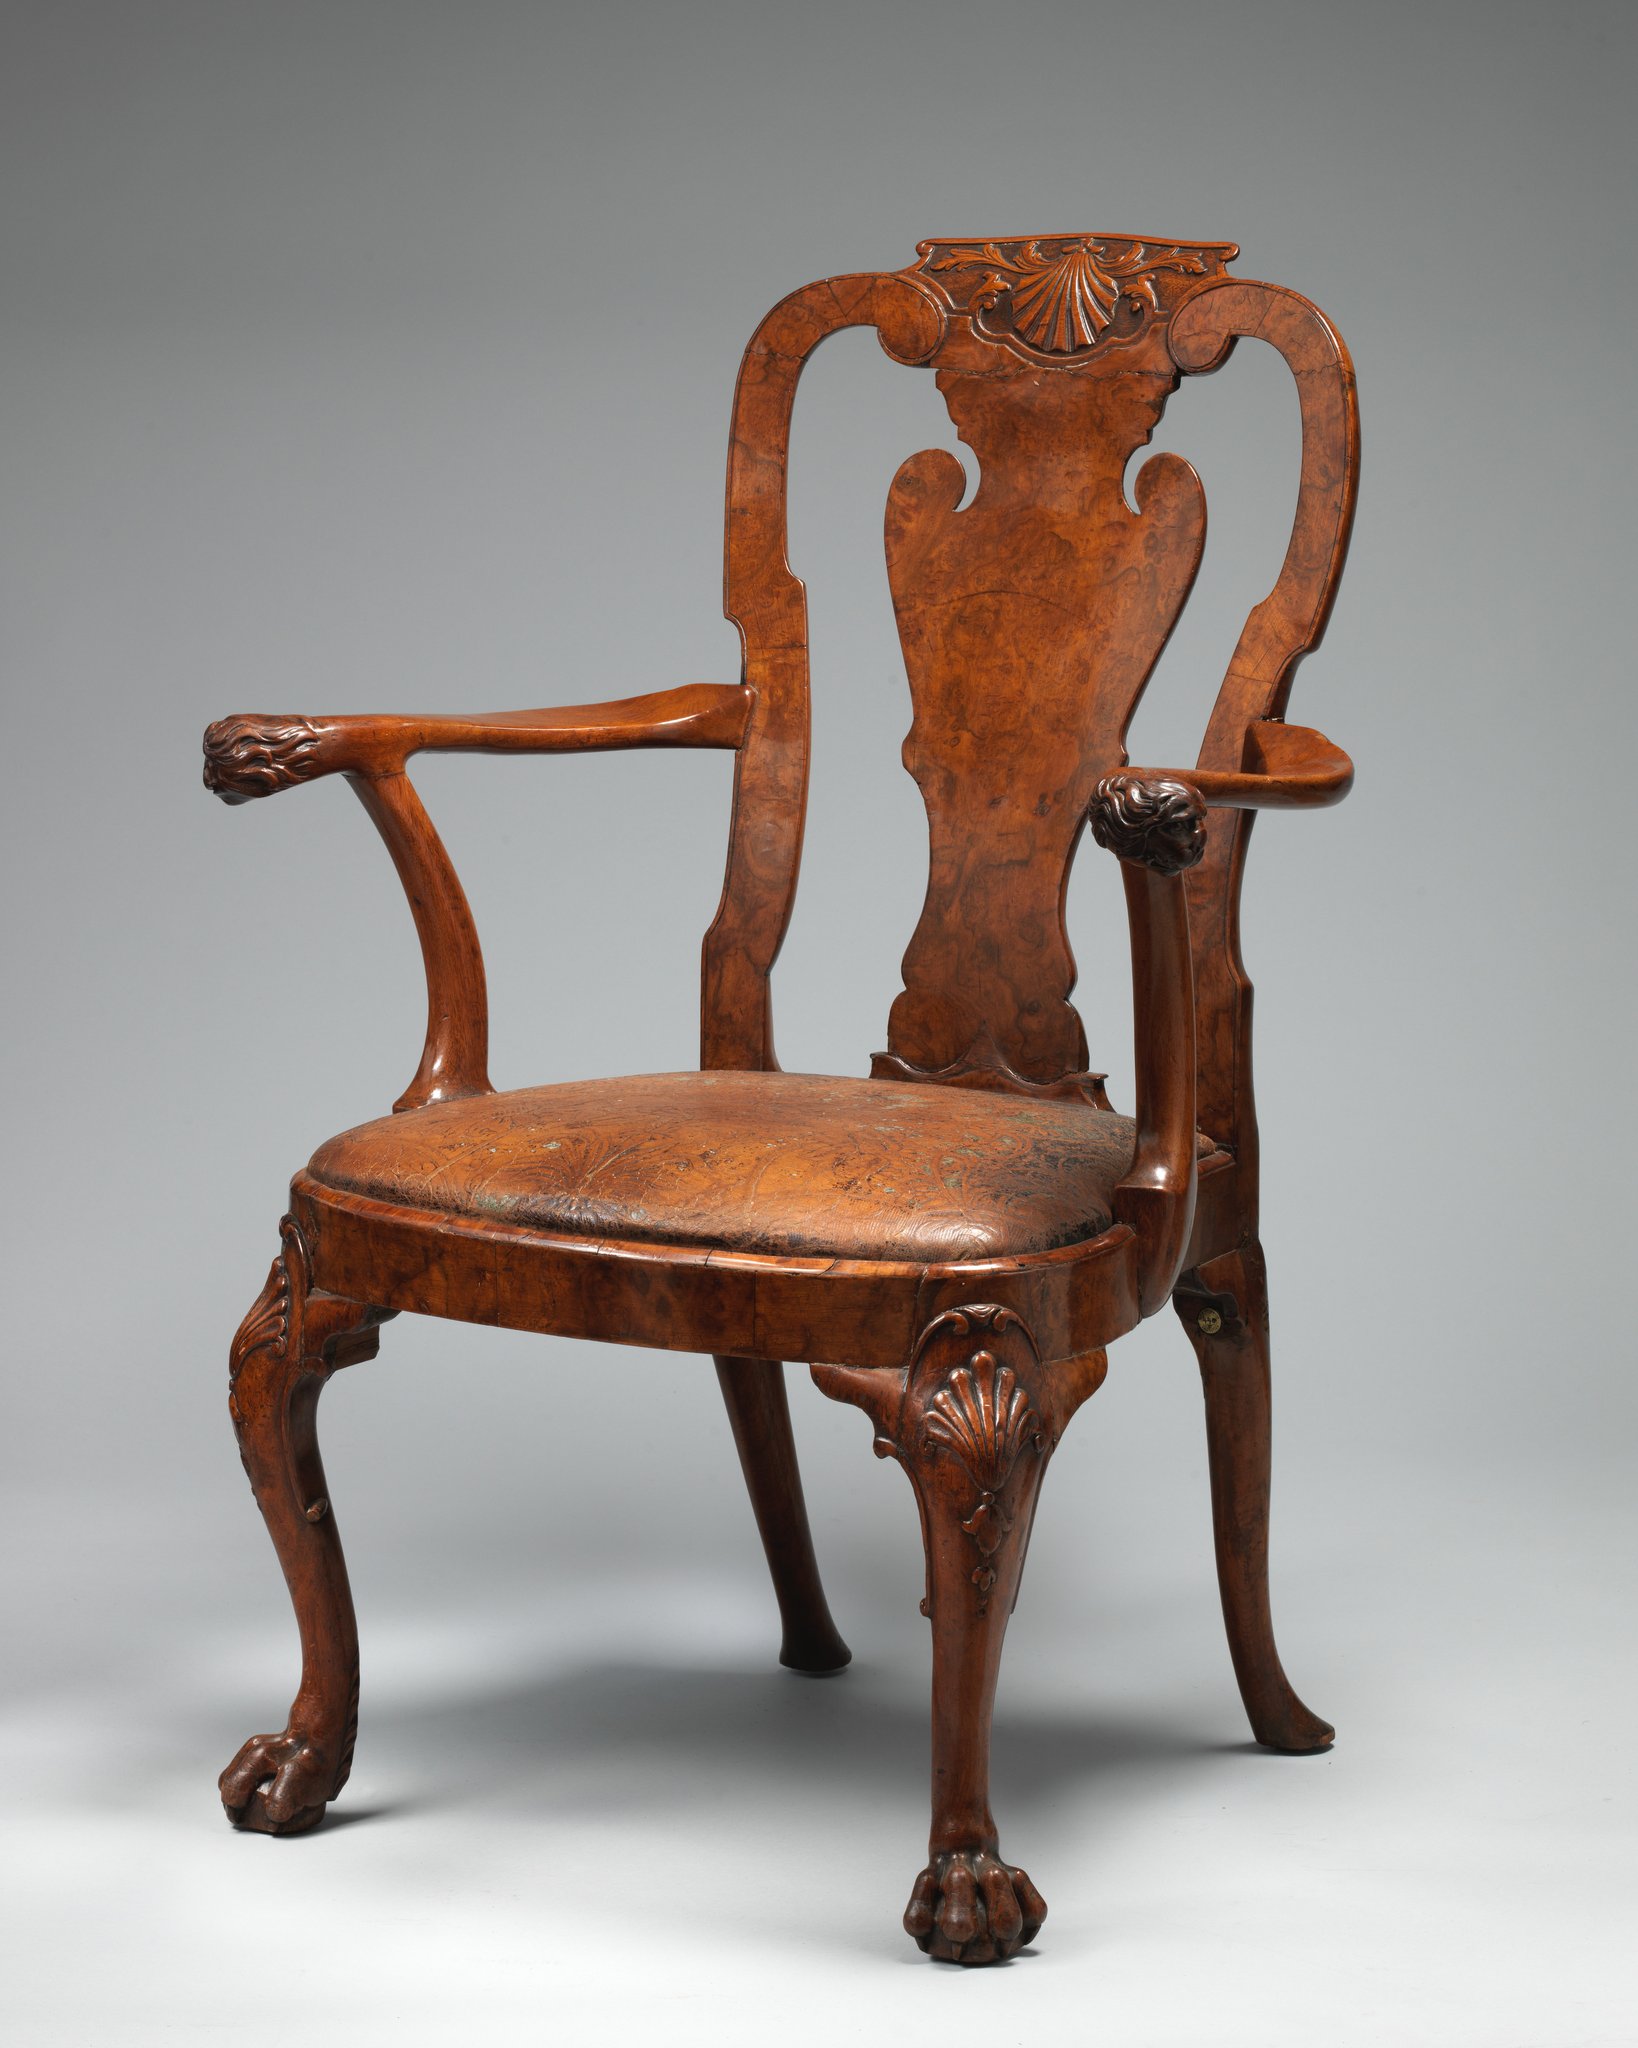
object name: armchair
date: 1730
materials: wood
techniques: veneering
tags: shells